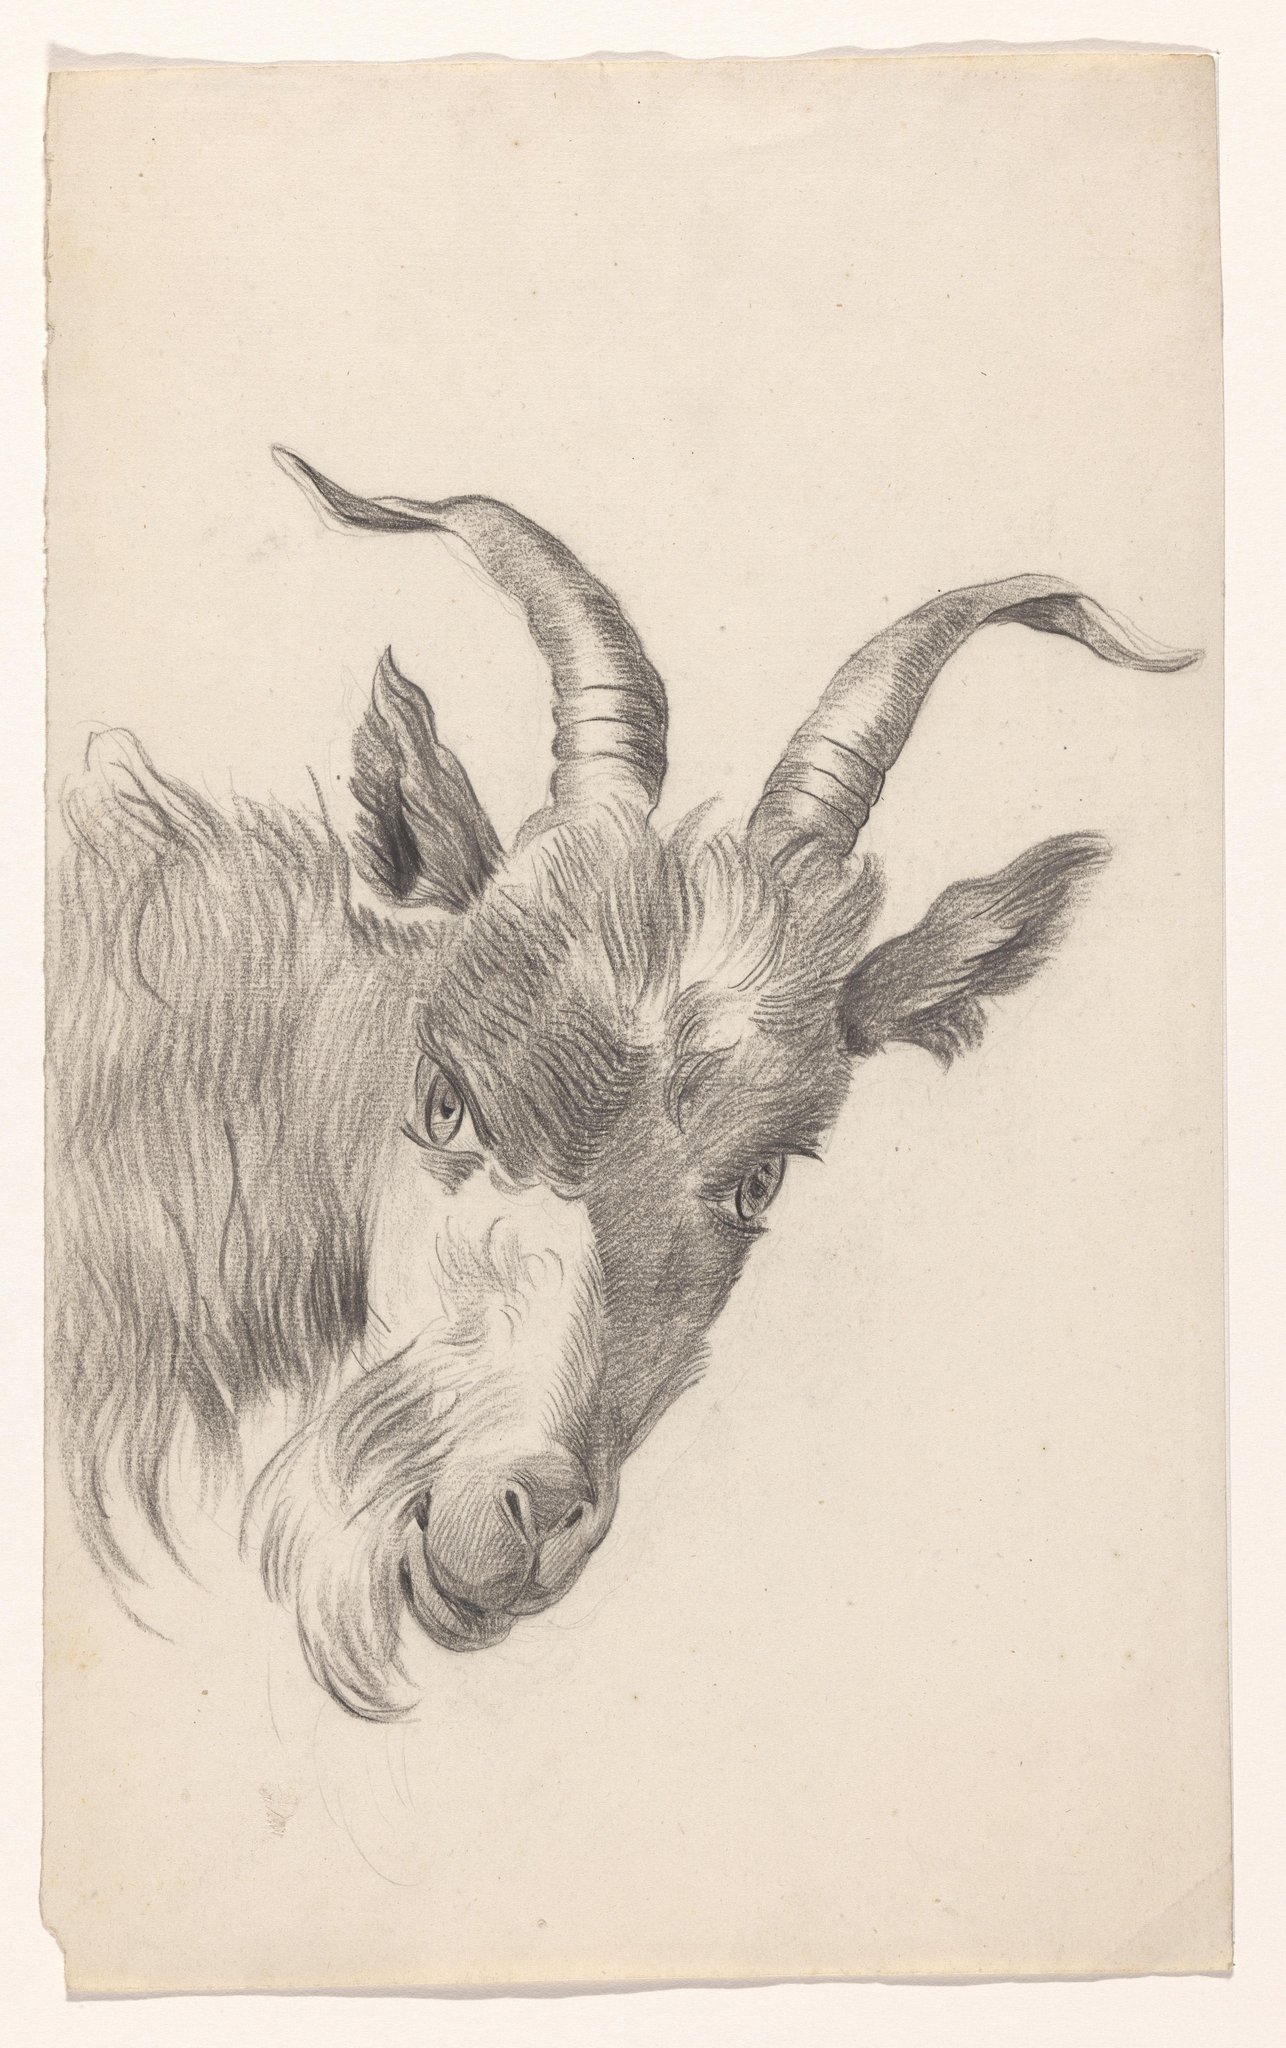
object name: drawing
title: Bokje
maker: joannes carolus alberdingk thijm (jan)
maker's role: pater, schrijver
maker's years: 1847-1926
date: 1853-1860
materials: chalk, paper, pencil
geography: netherlands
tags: goat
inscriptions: inscription: ‘A.Th.’